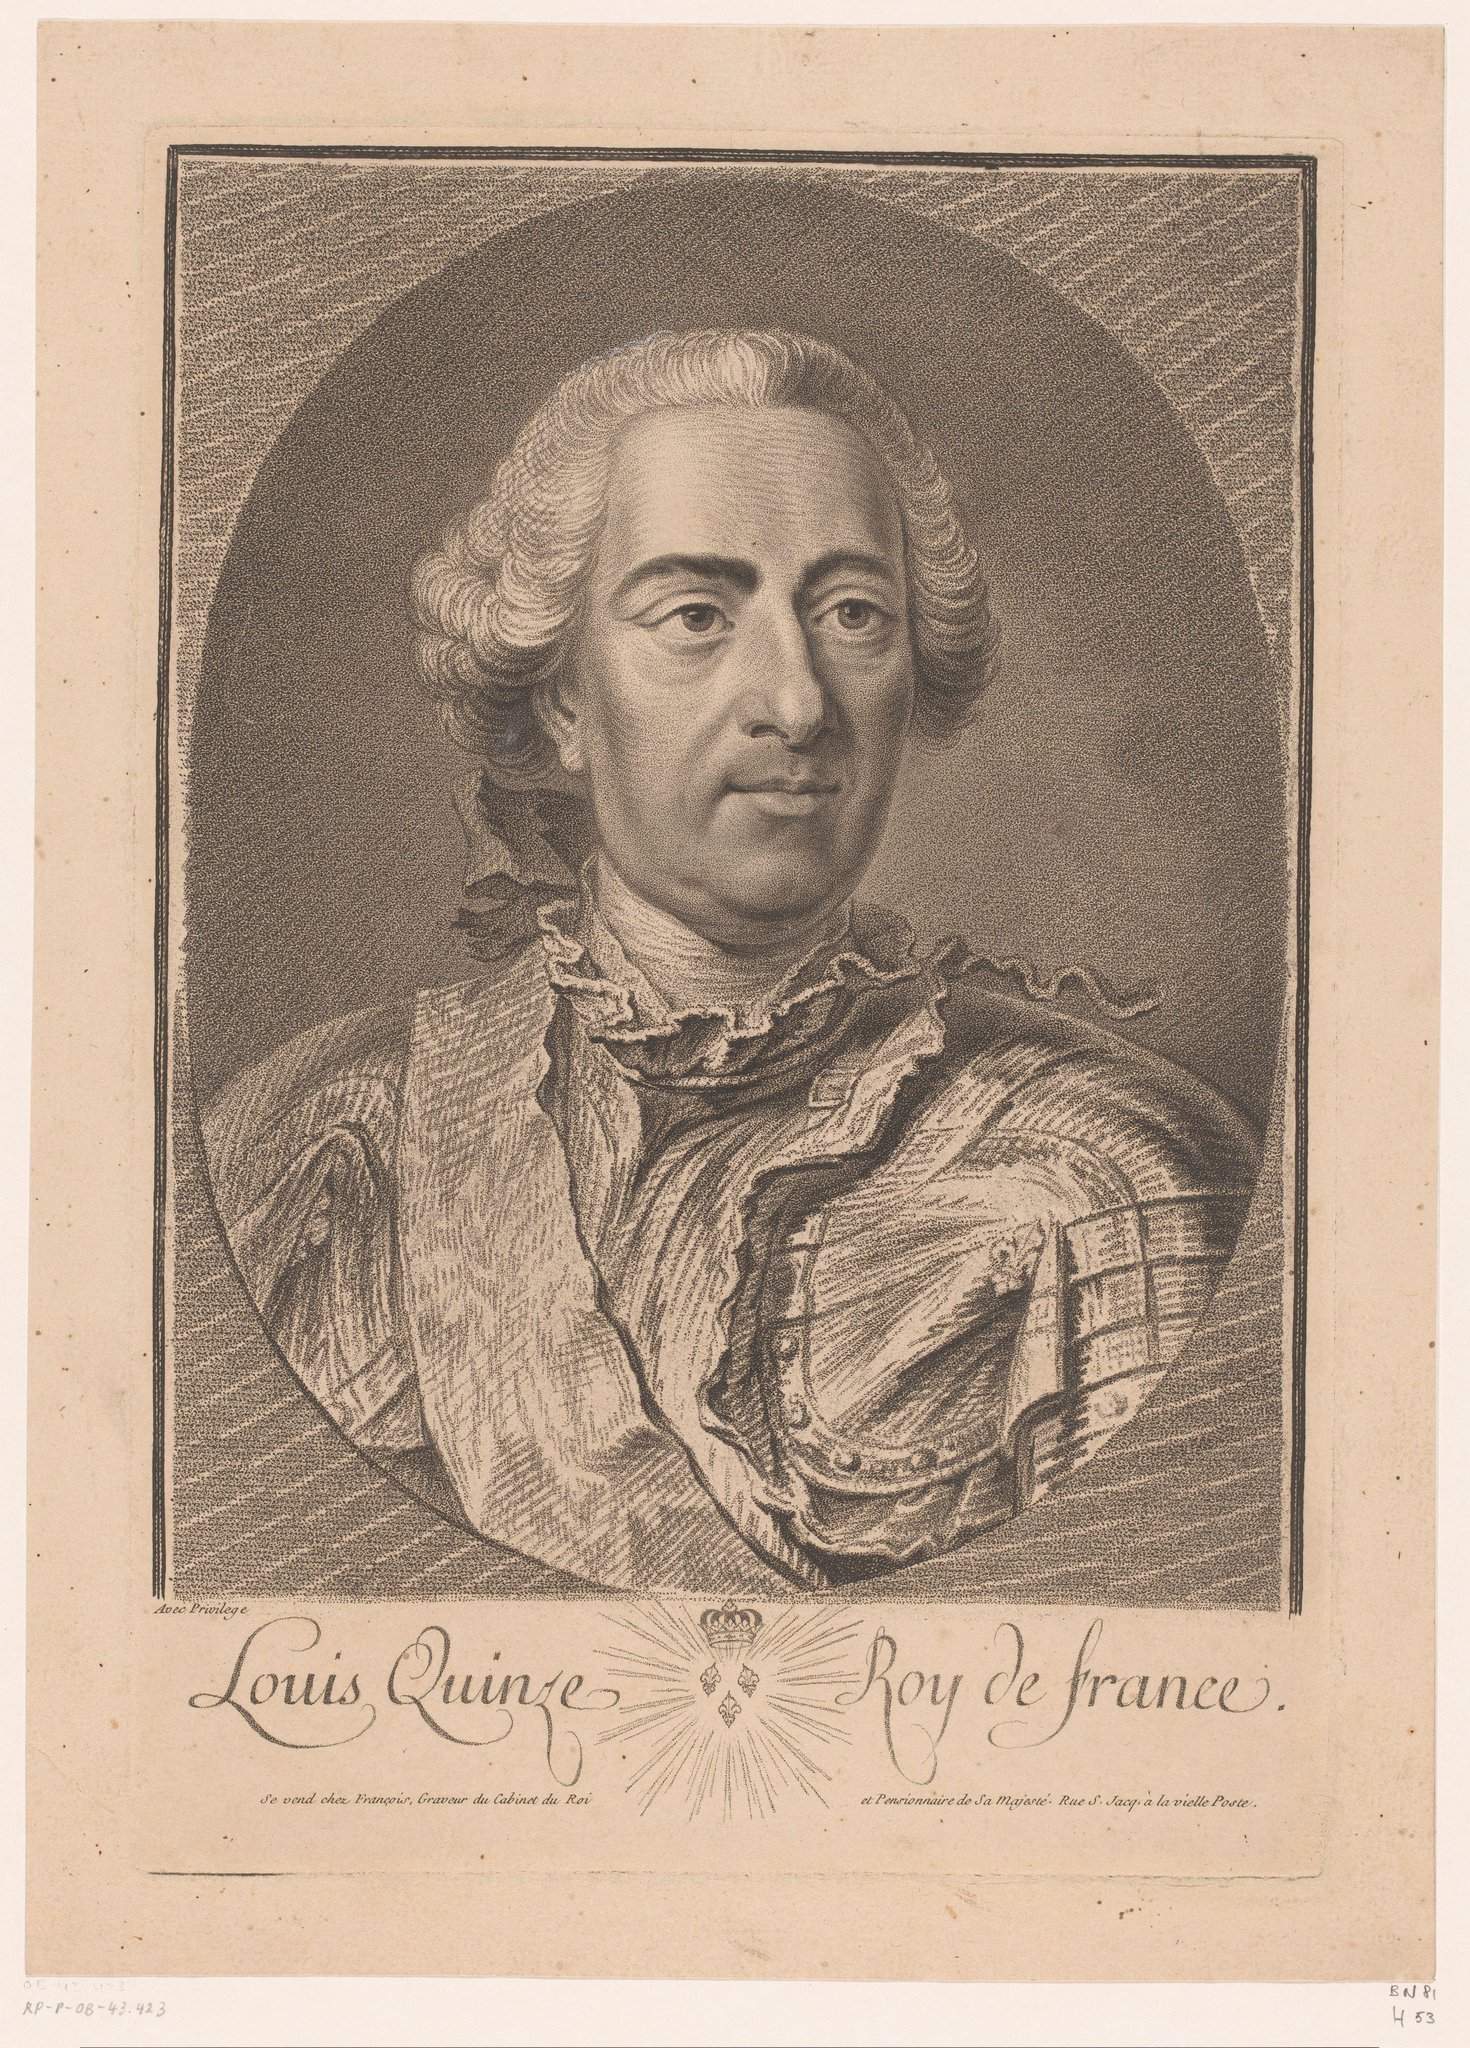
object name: print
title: Portret van Lodewijk XV van Frankrijk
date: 1727-1769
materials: paper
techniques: printmaking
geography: paris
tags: louis xv of france, historical persons, ruler, sovereign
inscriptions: collector's mark: Lugt 2228